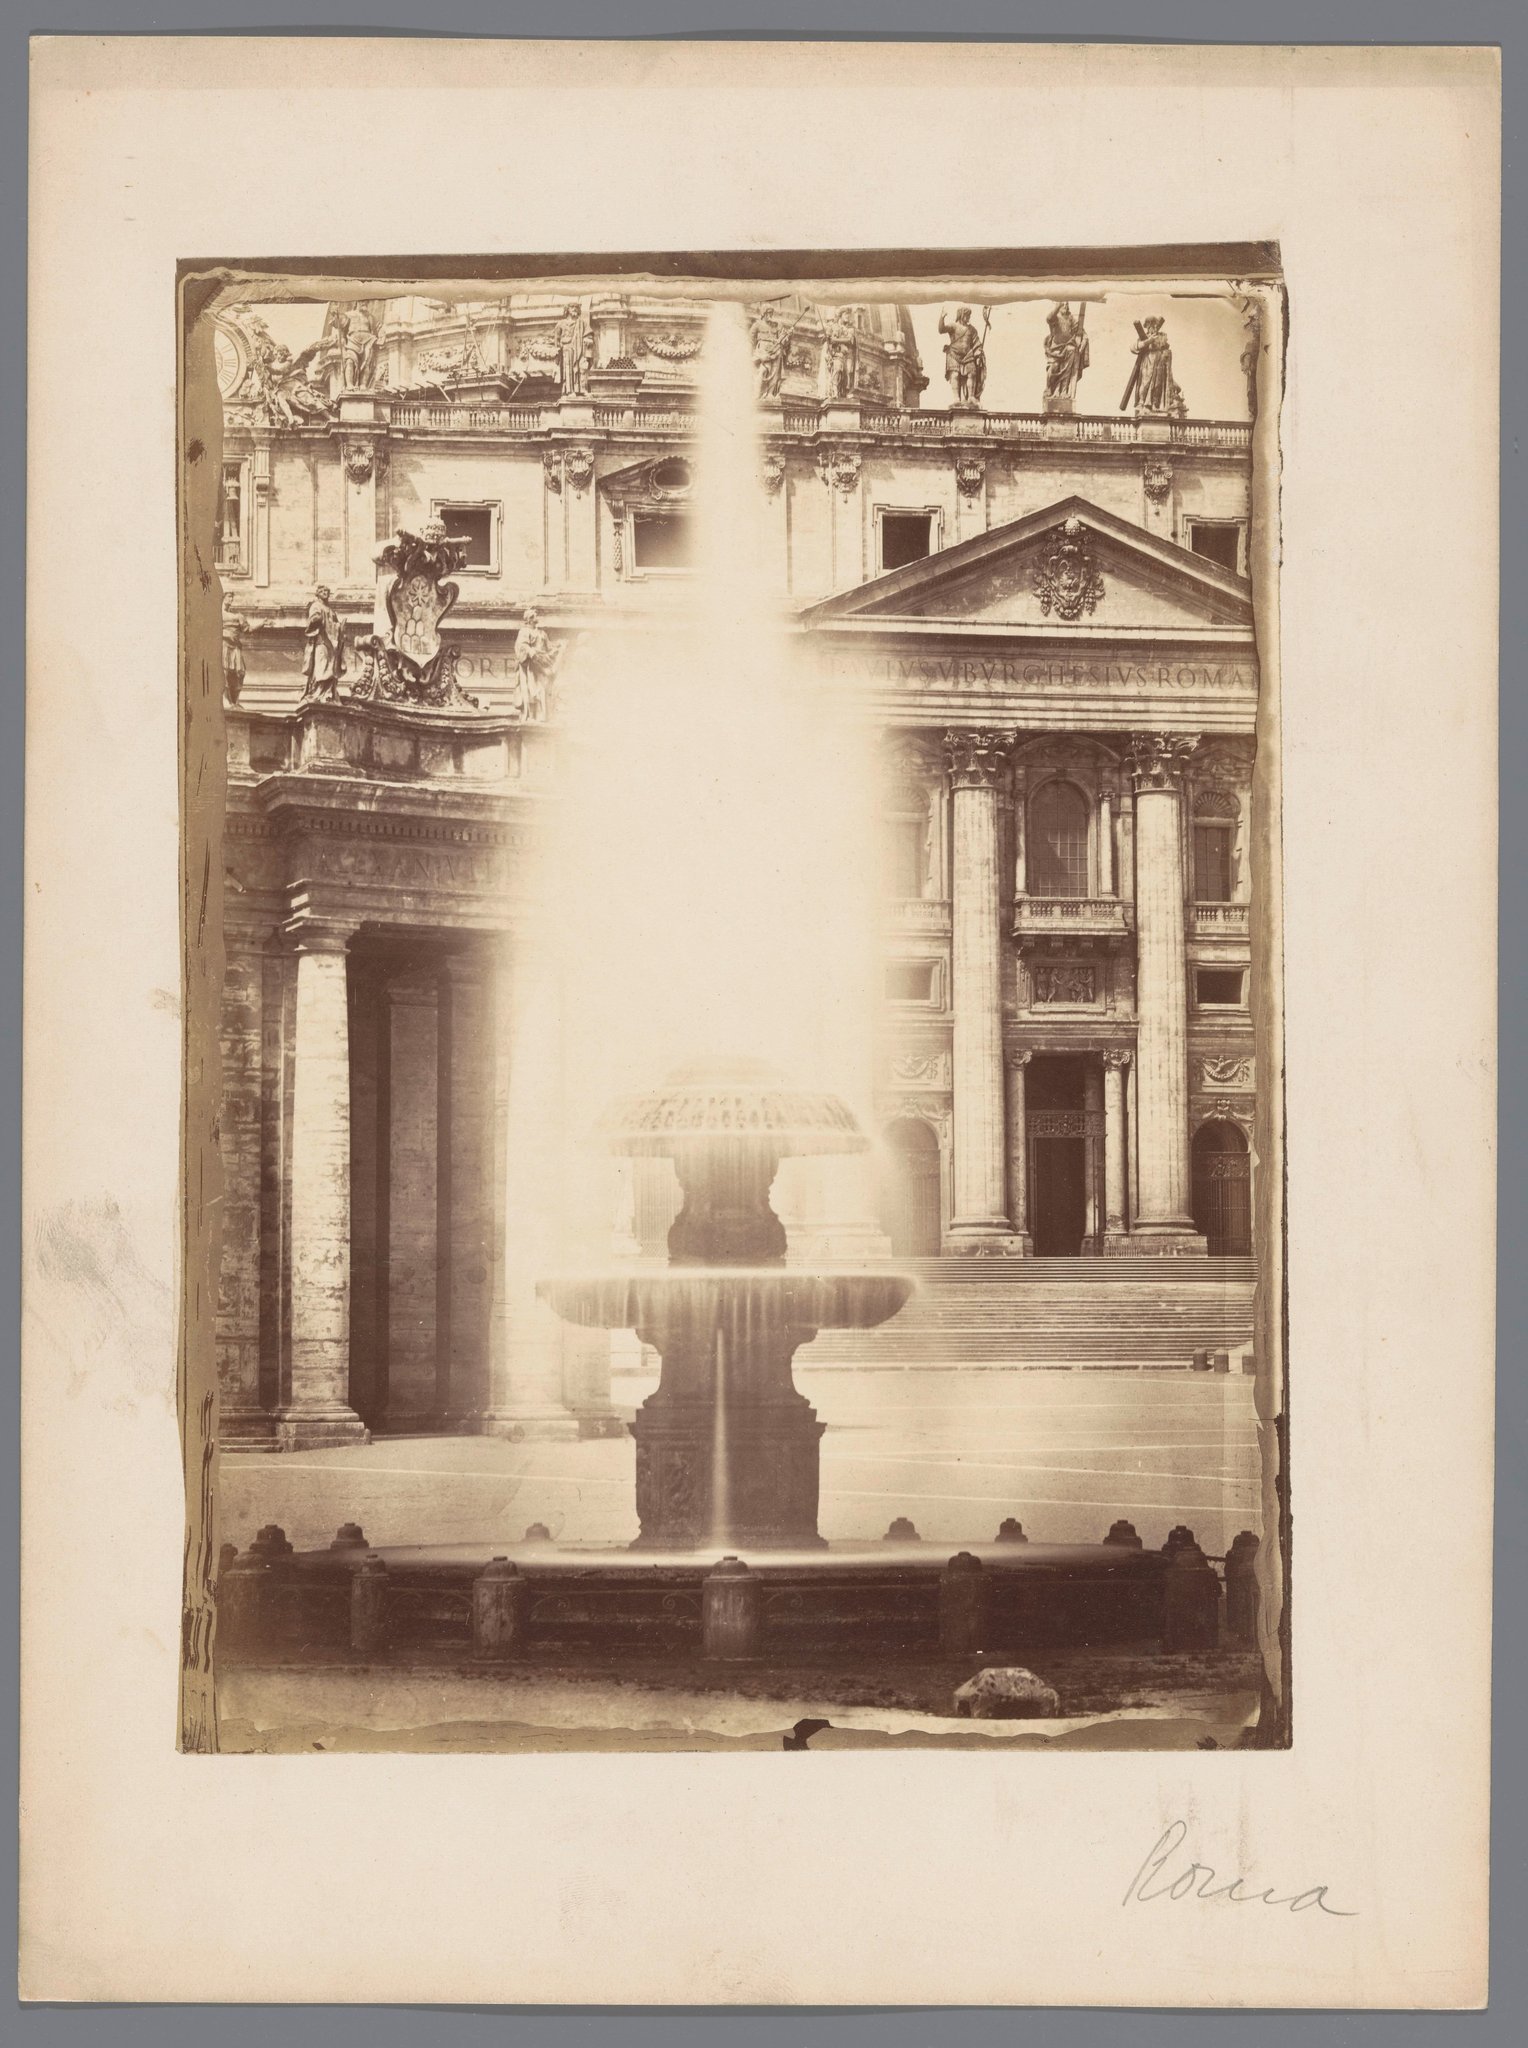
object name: photograph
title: Fontein op het Sint-Pietersplein te Vaticaanstad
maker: gustave eugène chauffourier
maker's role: fotograaf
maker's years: 1845-1919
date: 1875-1900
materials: photographic support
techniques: albumen print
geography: sint-pietersplein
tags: square, place, circus, etc., ornamental fountain, exterior ~ representation of a building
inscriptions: collector's mark: Lugt 3937